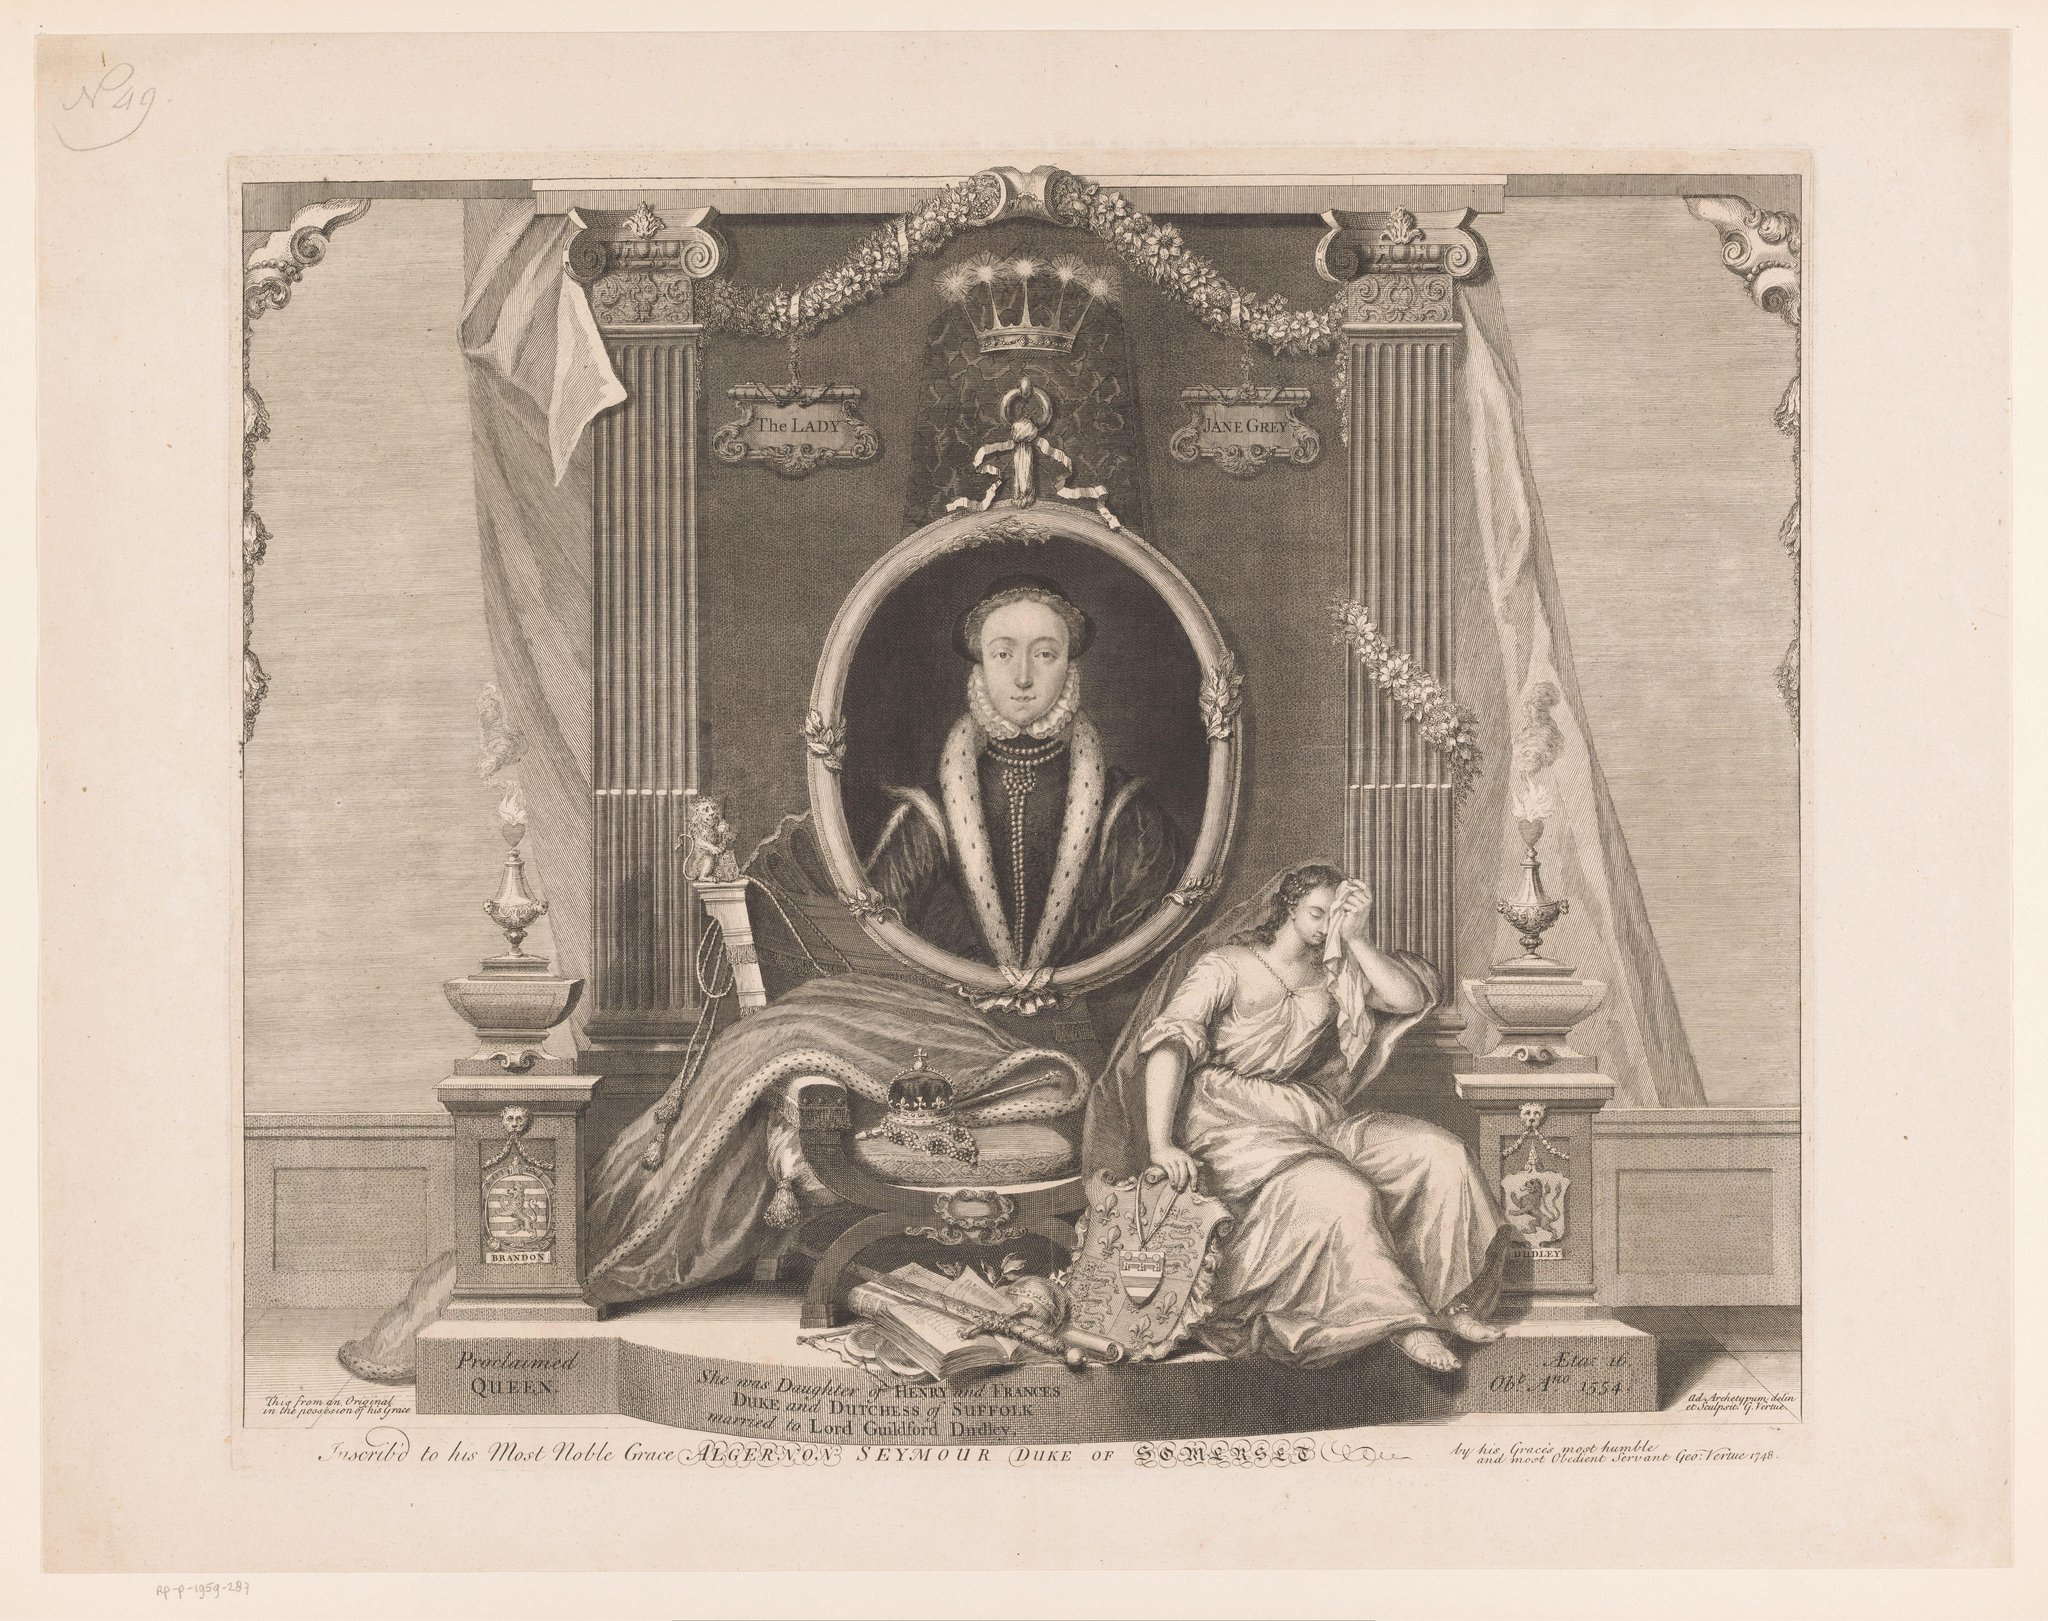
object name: print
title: The Lady Jane Grey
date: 1748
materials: paper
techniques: etching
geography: london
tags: crown (symbol of sovereignty), historical persons - bb - woman, armorial bearing, heraldry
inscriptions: collector's mark: Lugt 2228, collector's mark: Lugt 2760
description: Het portret is van Elizabeth I als prinses en niet van Jane Grey. Prent hoort bij een serie van negen prenten naar portretten van de Tudor-familie. De eerste vier werden in 1743 uitgegeven. In 1748 werden weer vier prenten gepubliceerd en in 1750 een laatste.